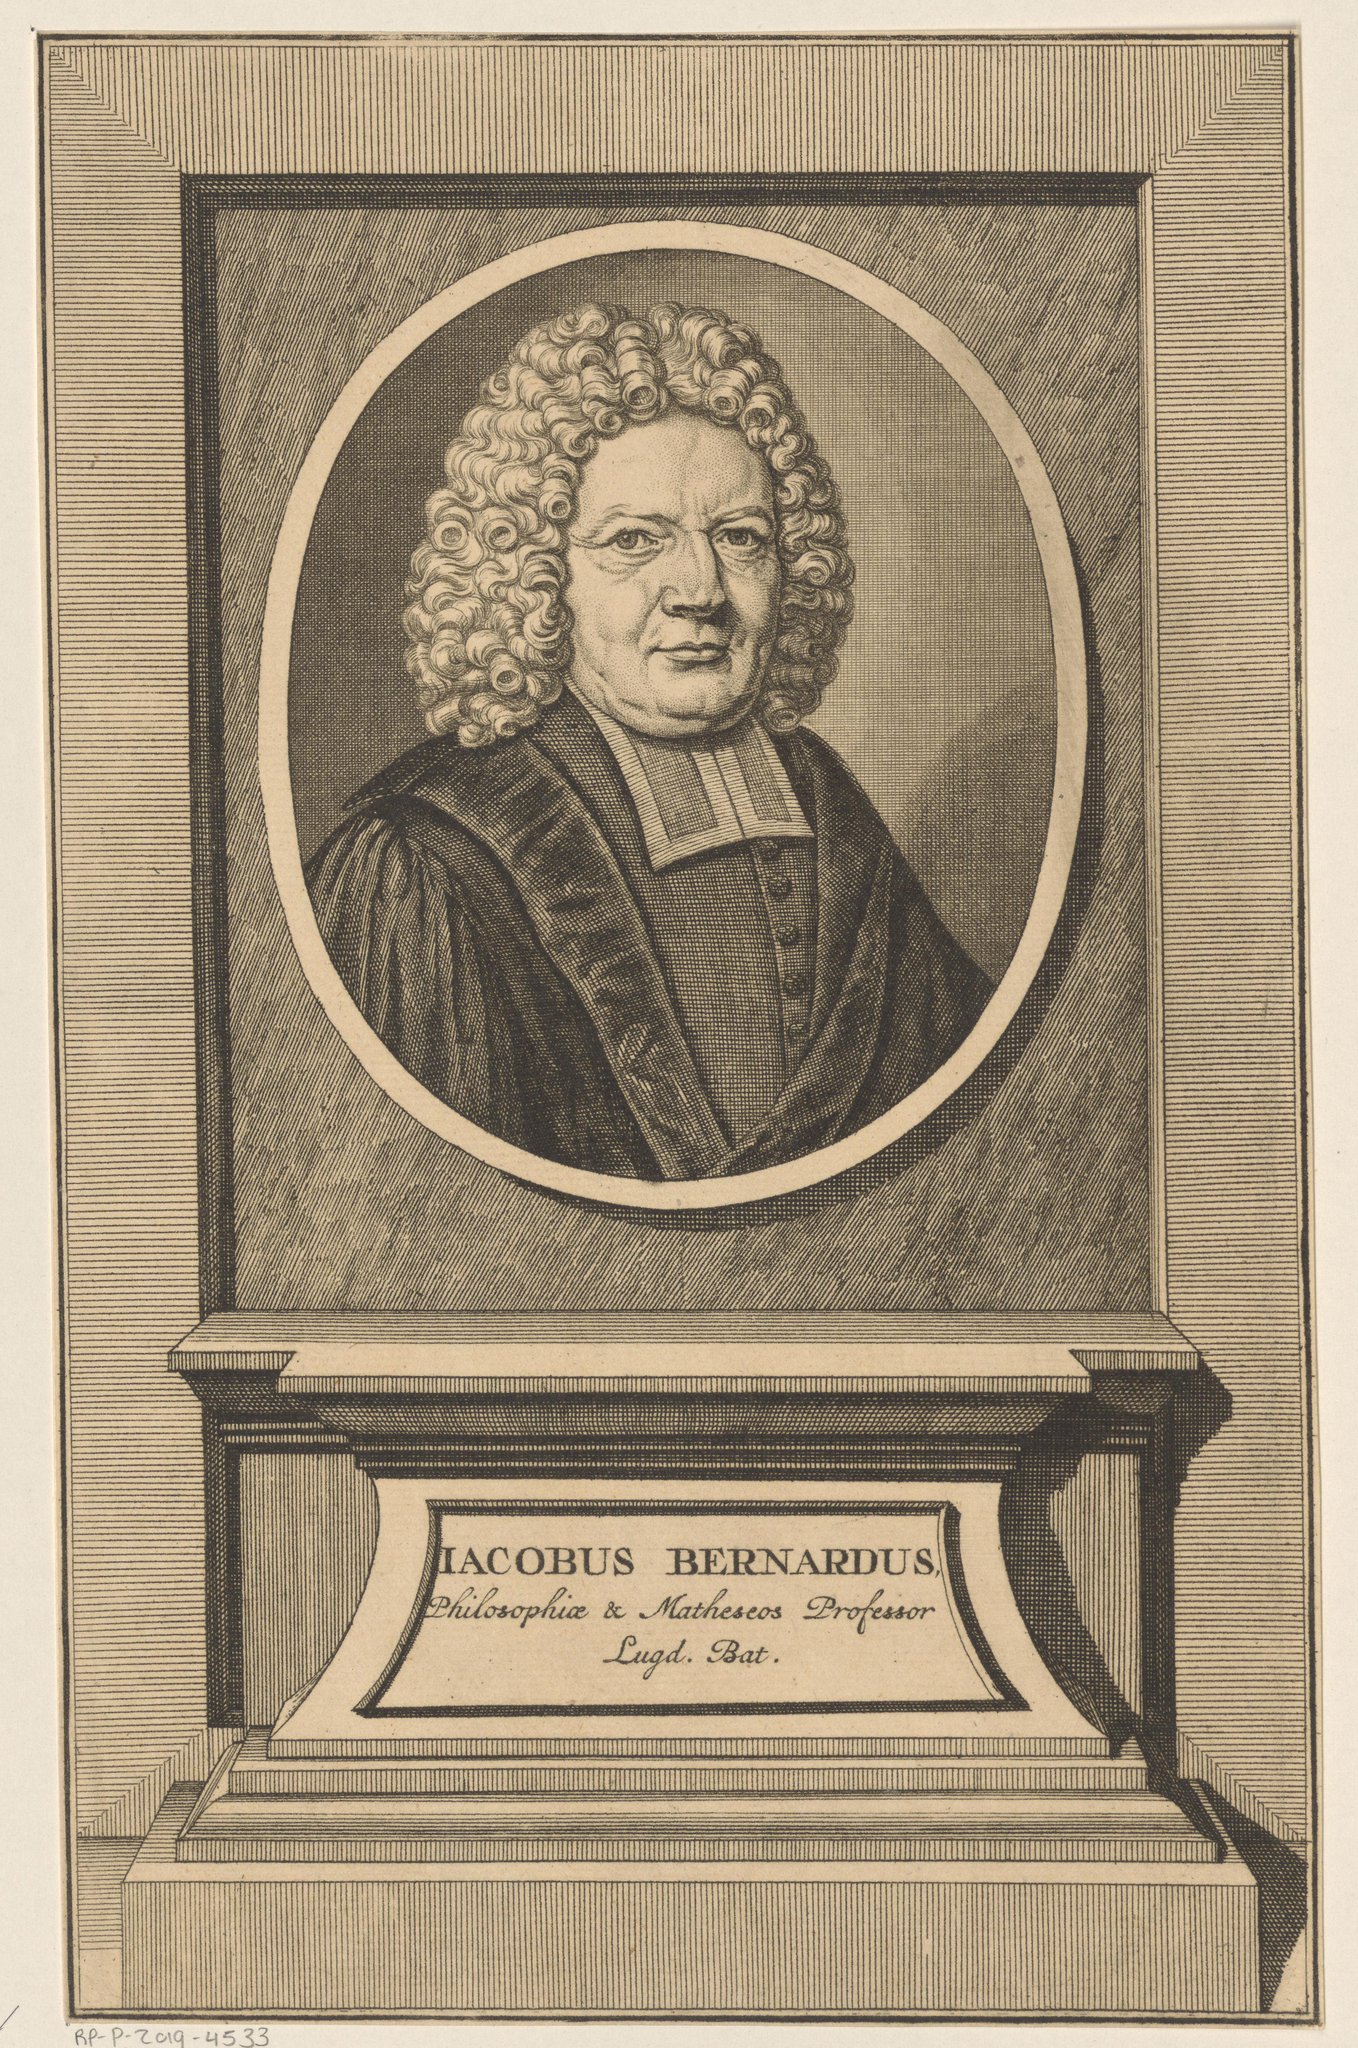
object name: print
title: Portret van Jacques Bernard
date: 1716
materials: paper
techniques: engraving, etching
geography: leiden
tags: theologian, historical persons